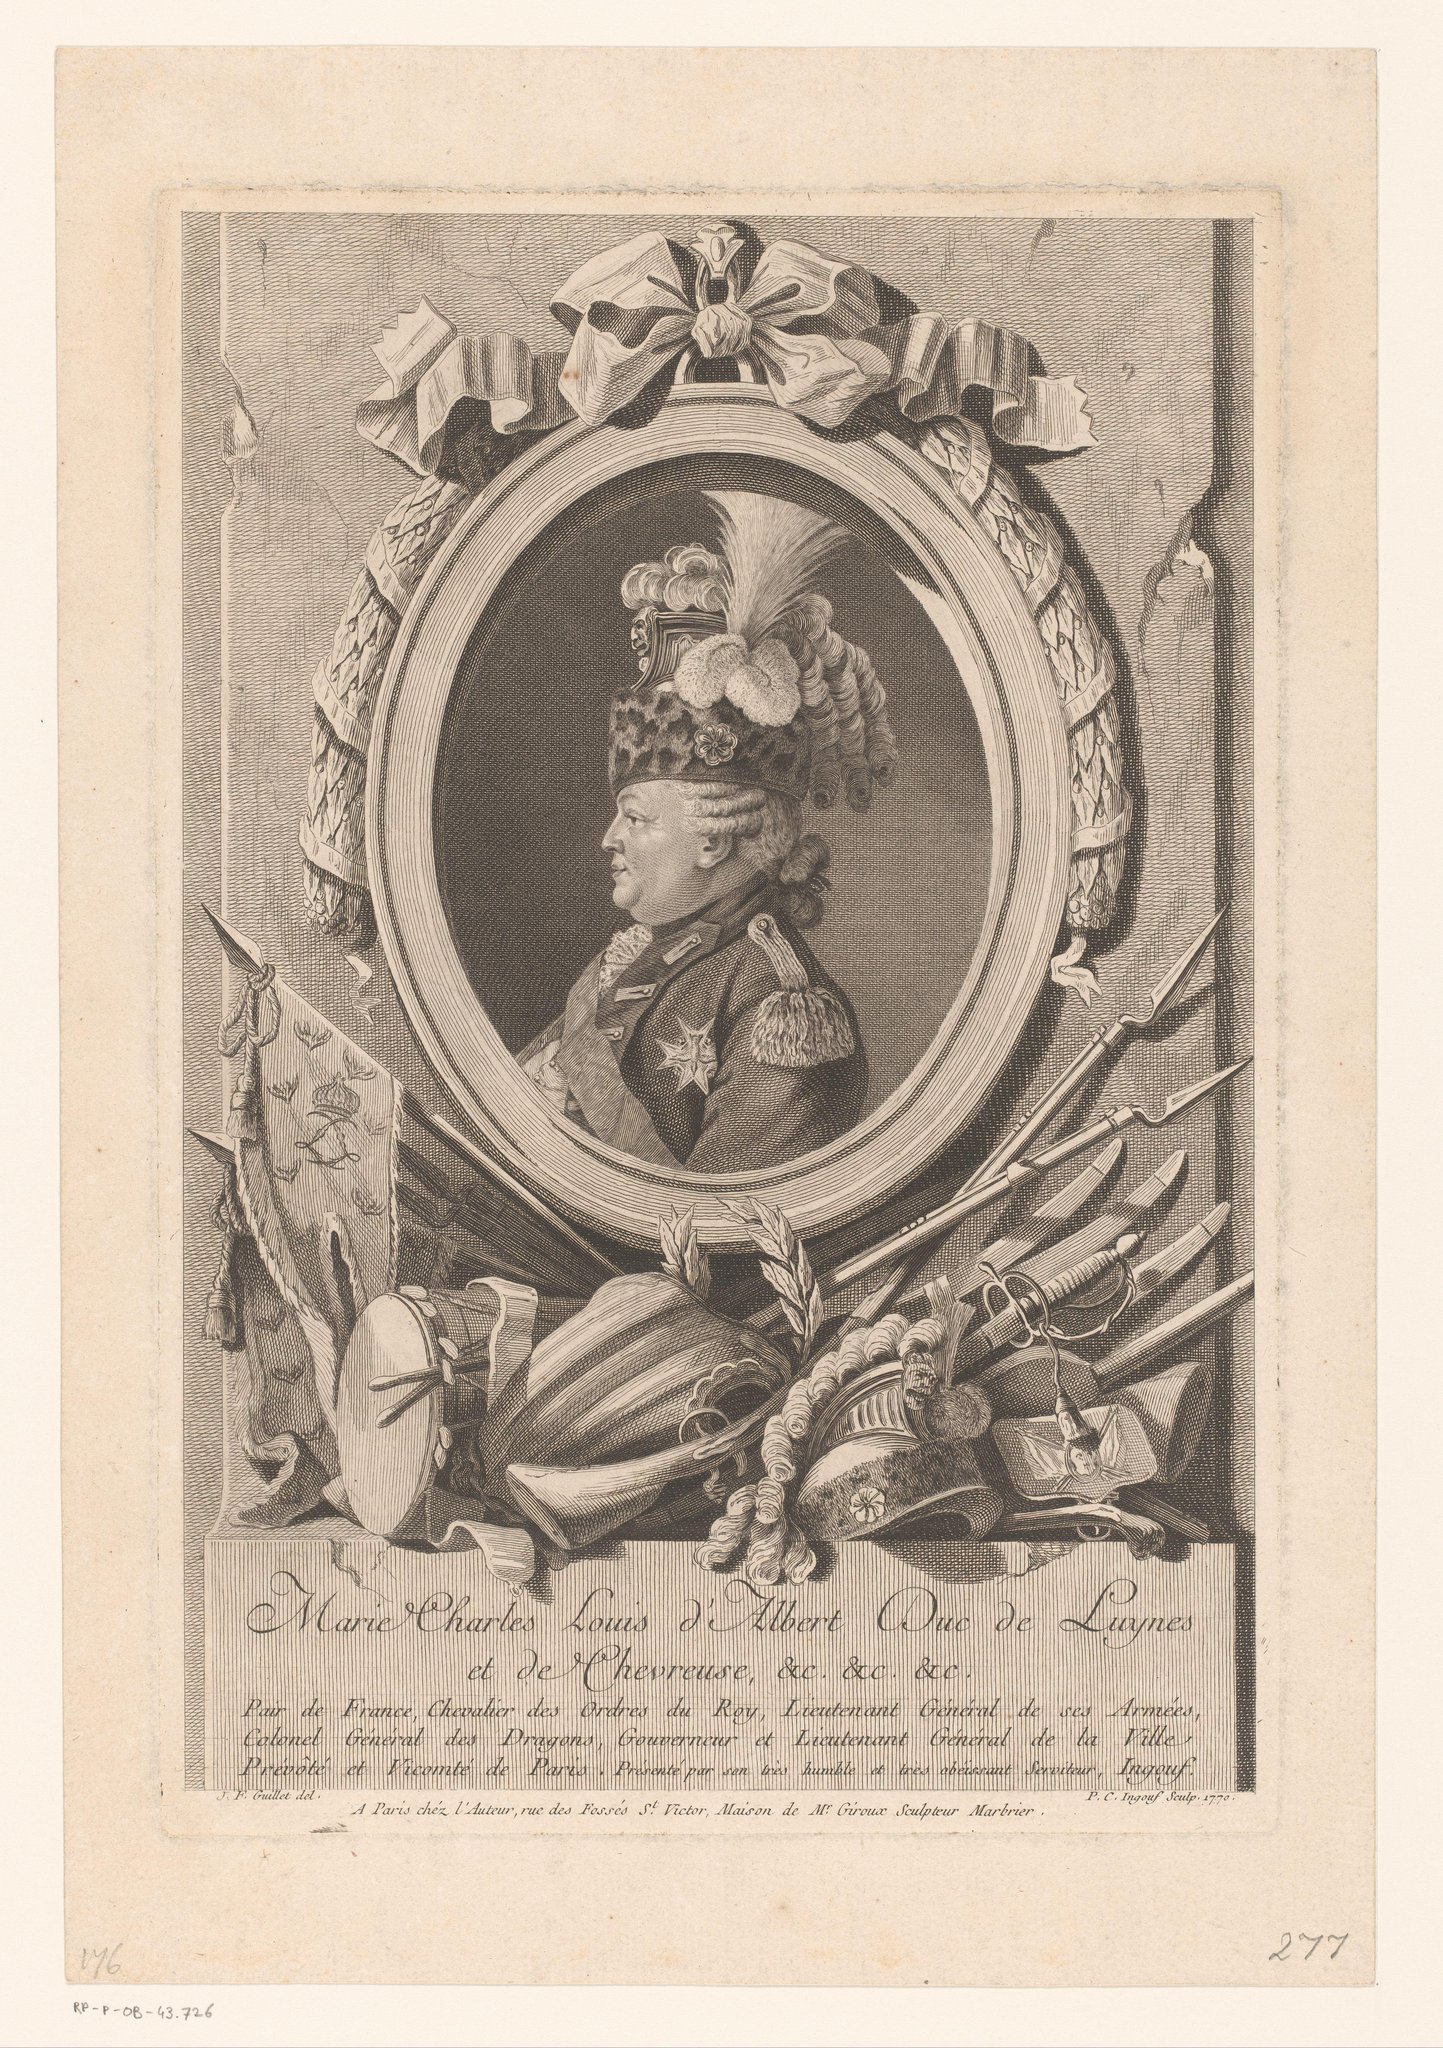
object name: print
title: Portret van Marie Charles Louis d'Albert Luynes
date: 1770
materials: paper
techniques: engraving, etching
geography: paris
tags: paris, marie charles louis d'albert luynes, historical persons, weapons, ornament ~ cartouche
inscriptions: date